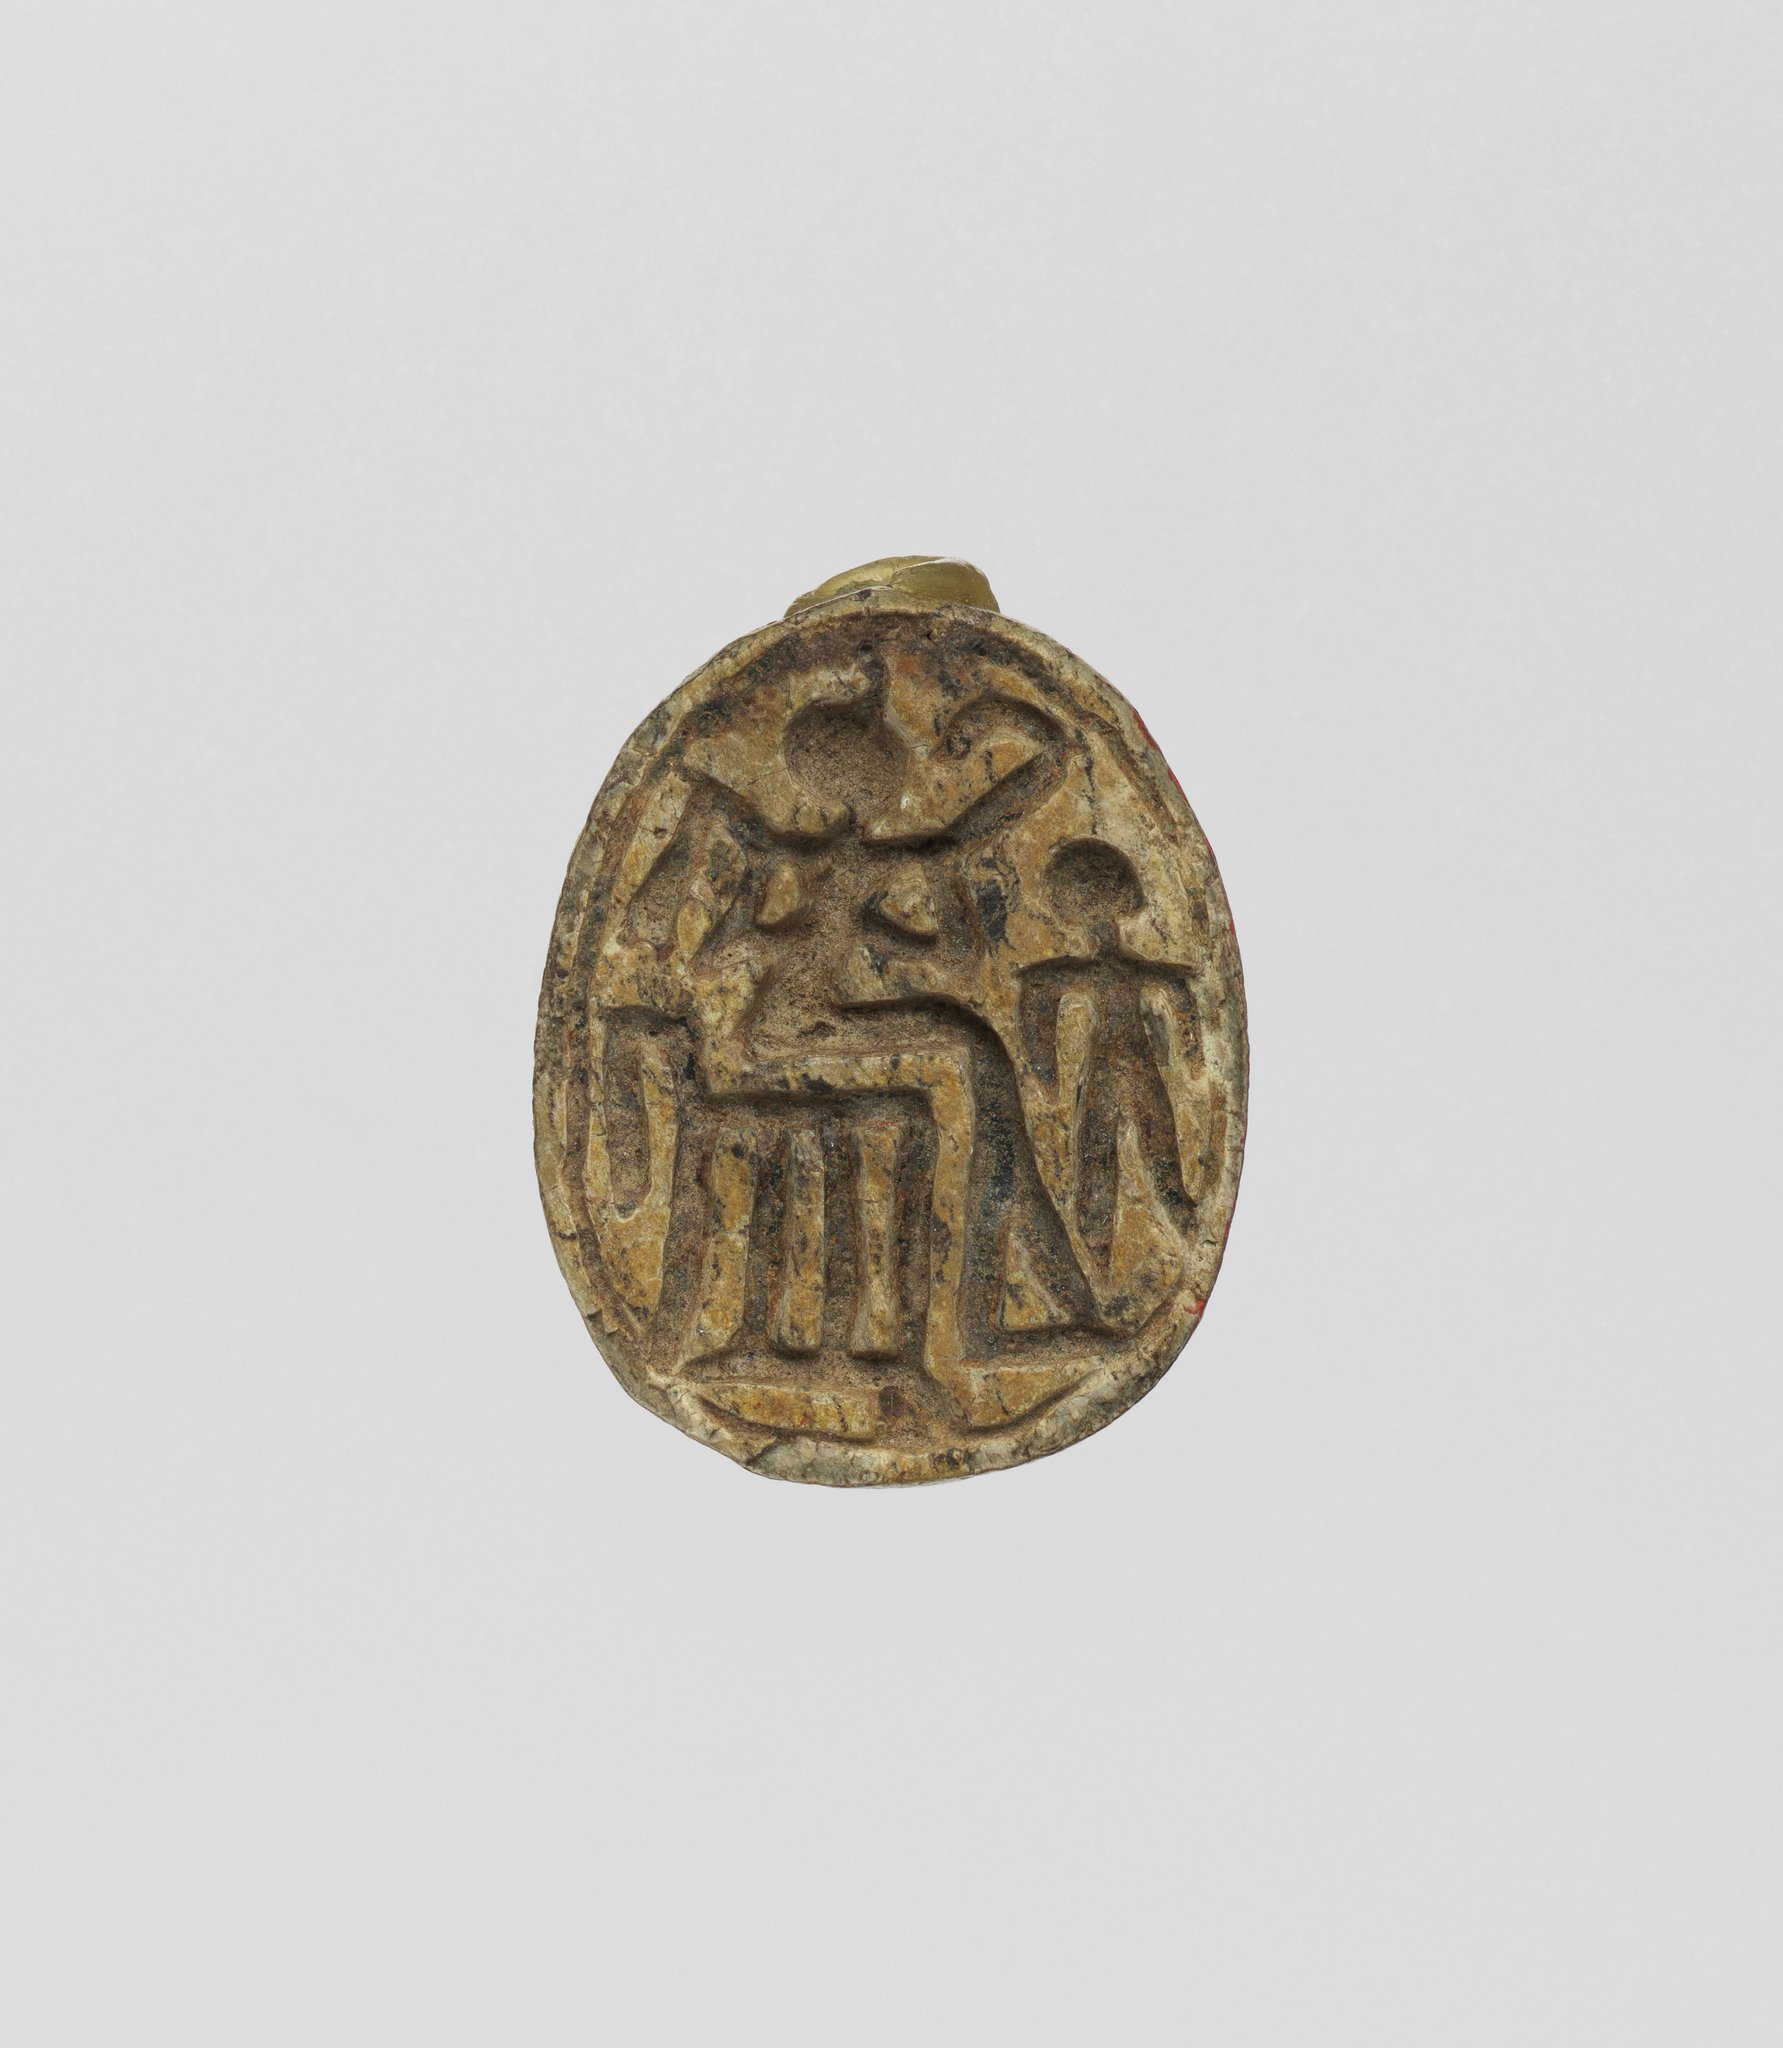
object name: scaraboid, human face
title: Scaraboid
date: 1295-1070 BCE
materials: faience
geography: egypt